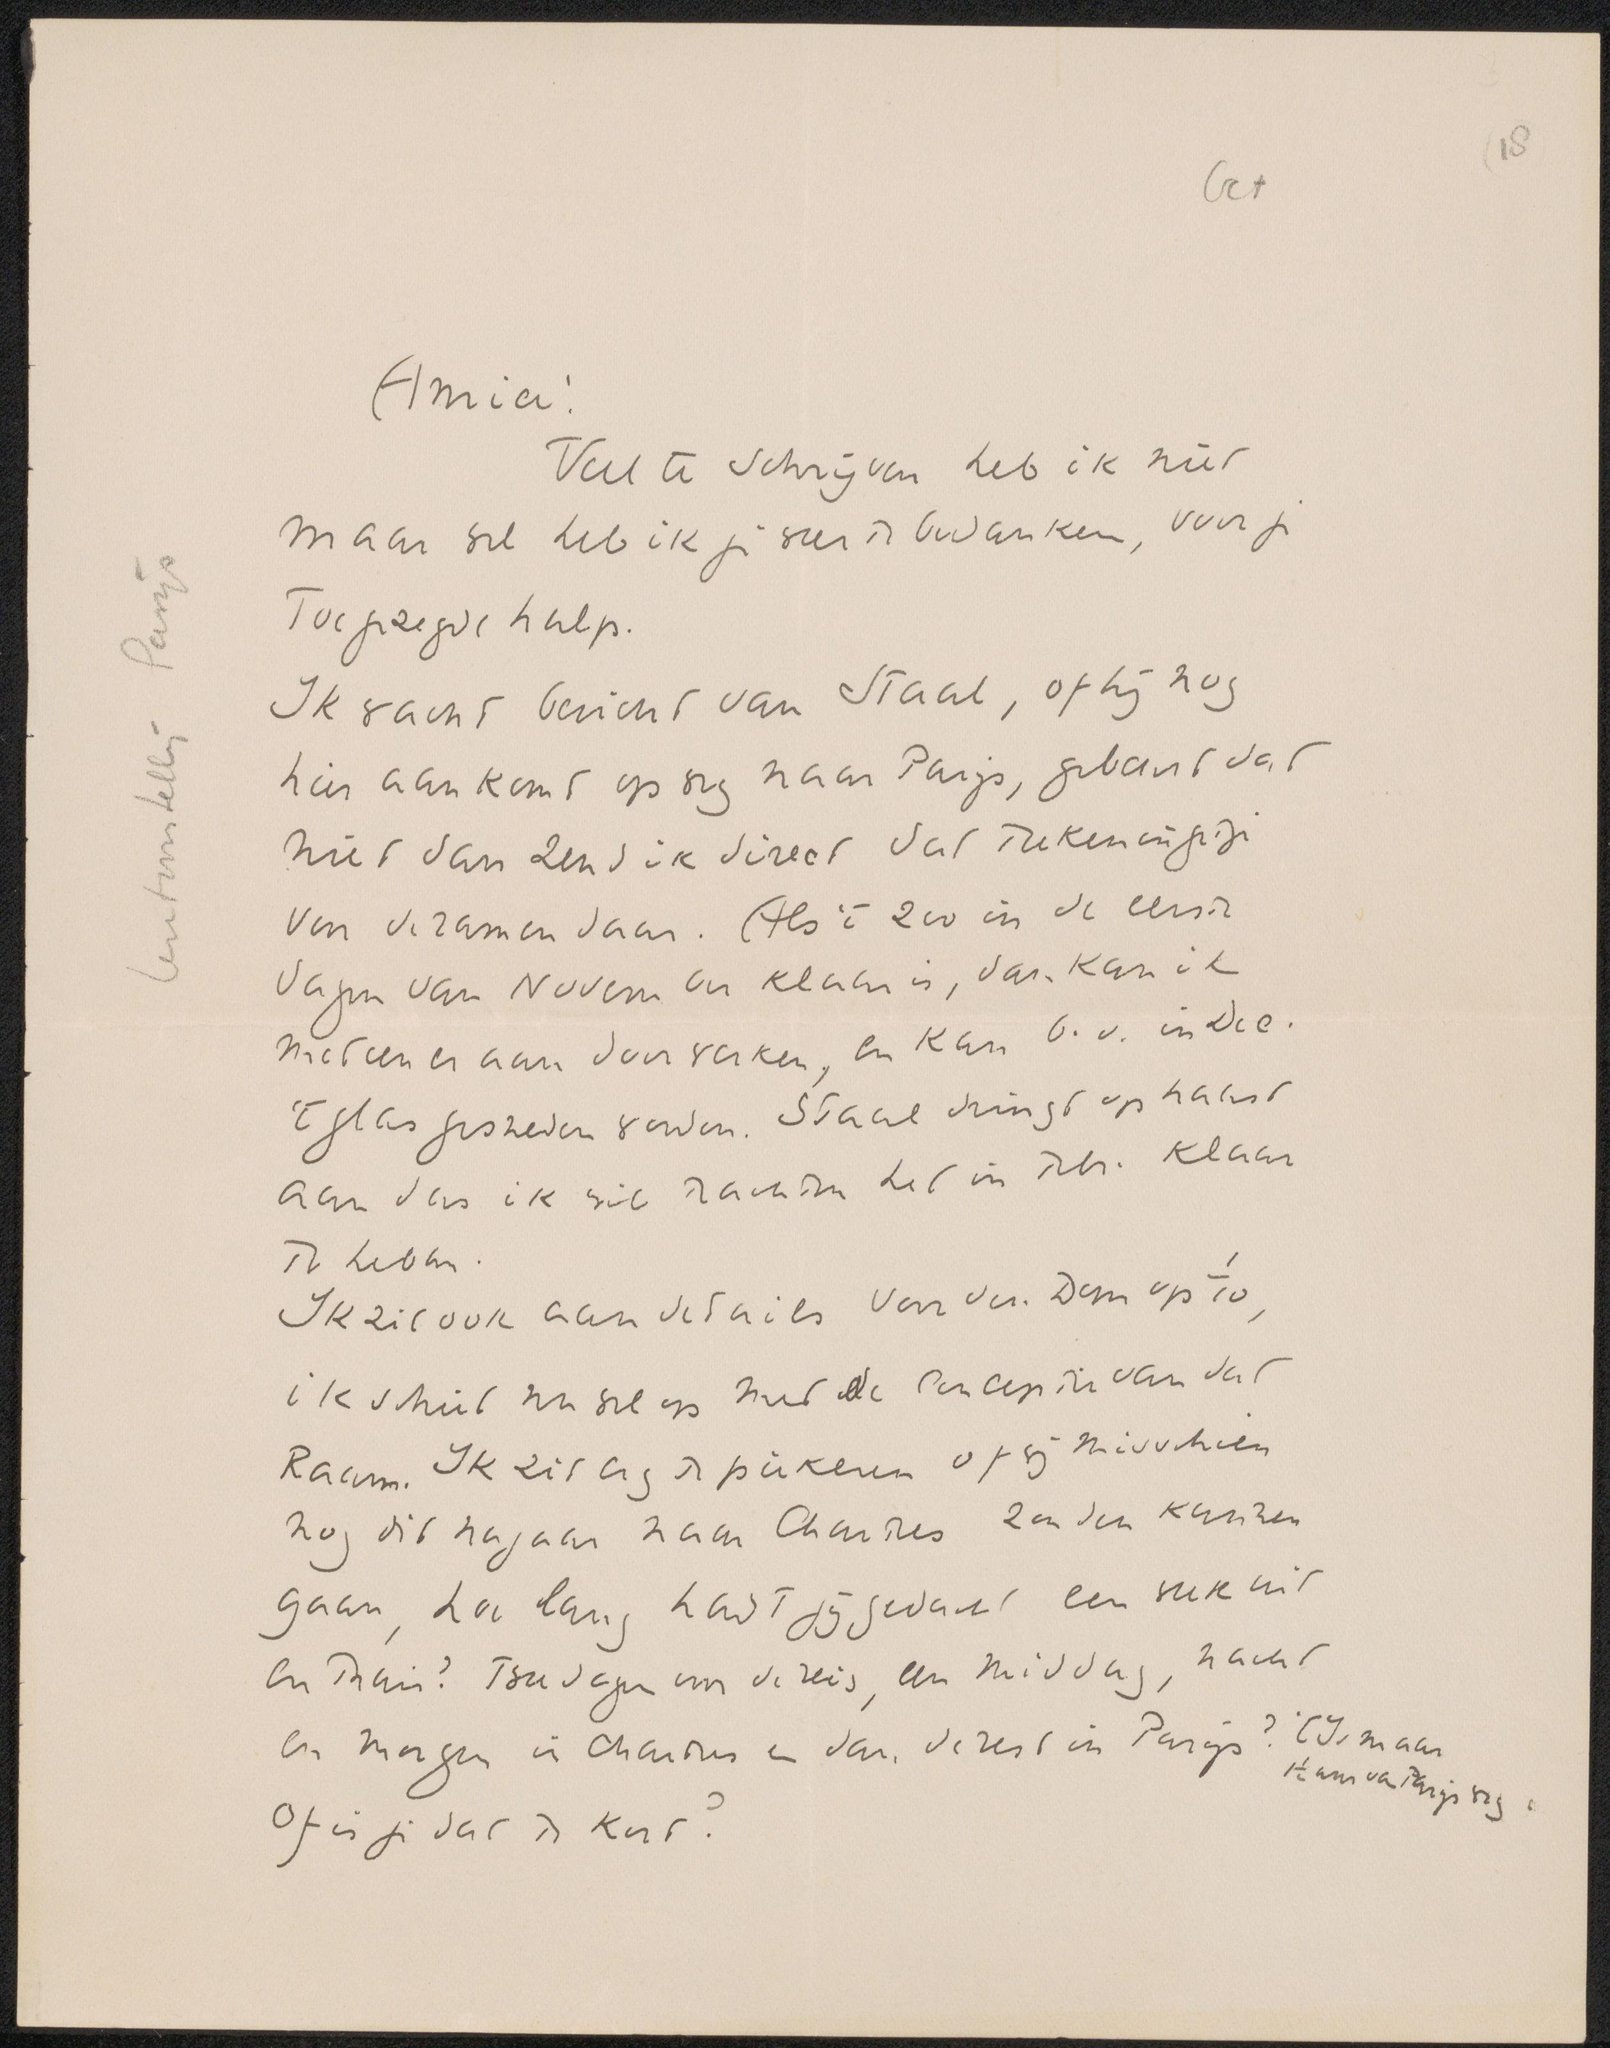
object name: letter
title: Brief aan Willem Bogtman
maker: richard nicolaüs roland holst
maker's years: 1868-1938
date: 1923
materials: ink, paper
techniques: pen, writing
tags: willem bogtman, amsterdam, designer, jan frederik staal, applied arts, arts and crafts; industrial design, exhibition ~ art, paris